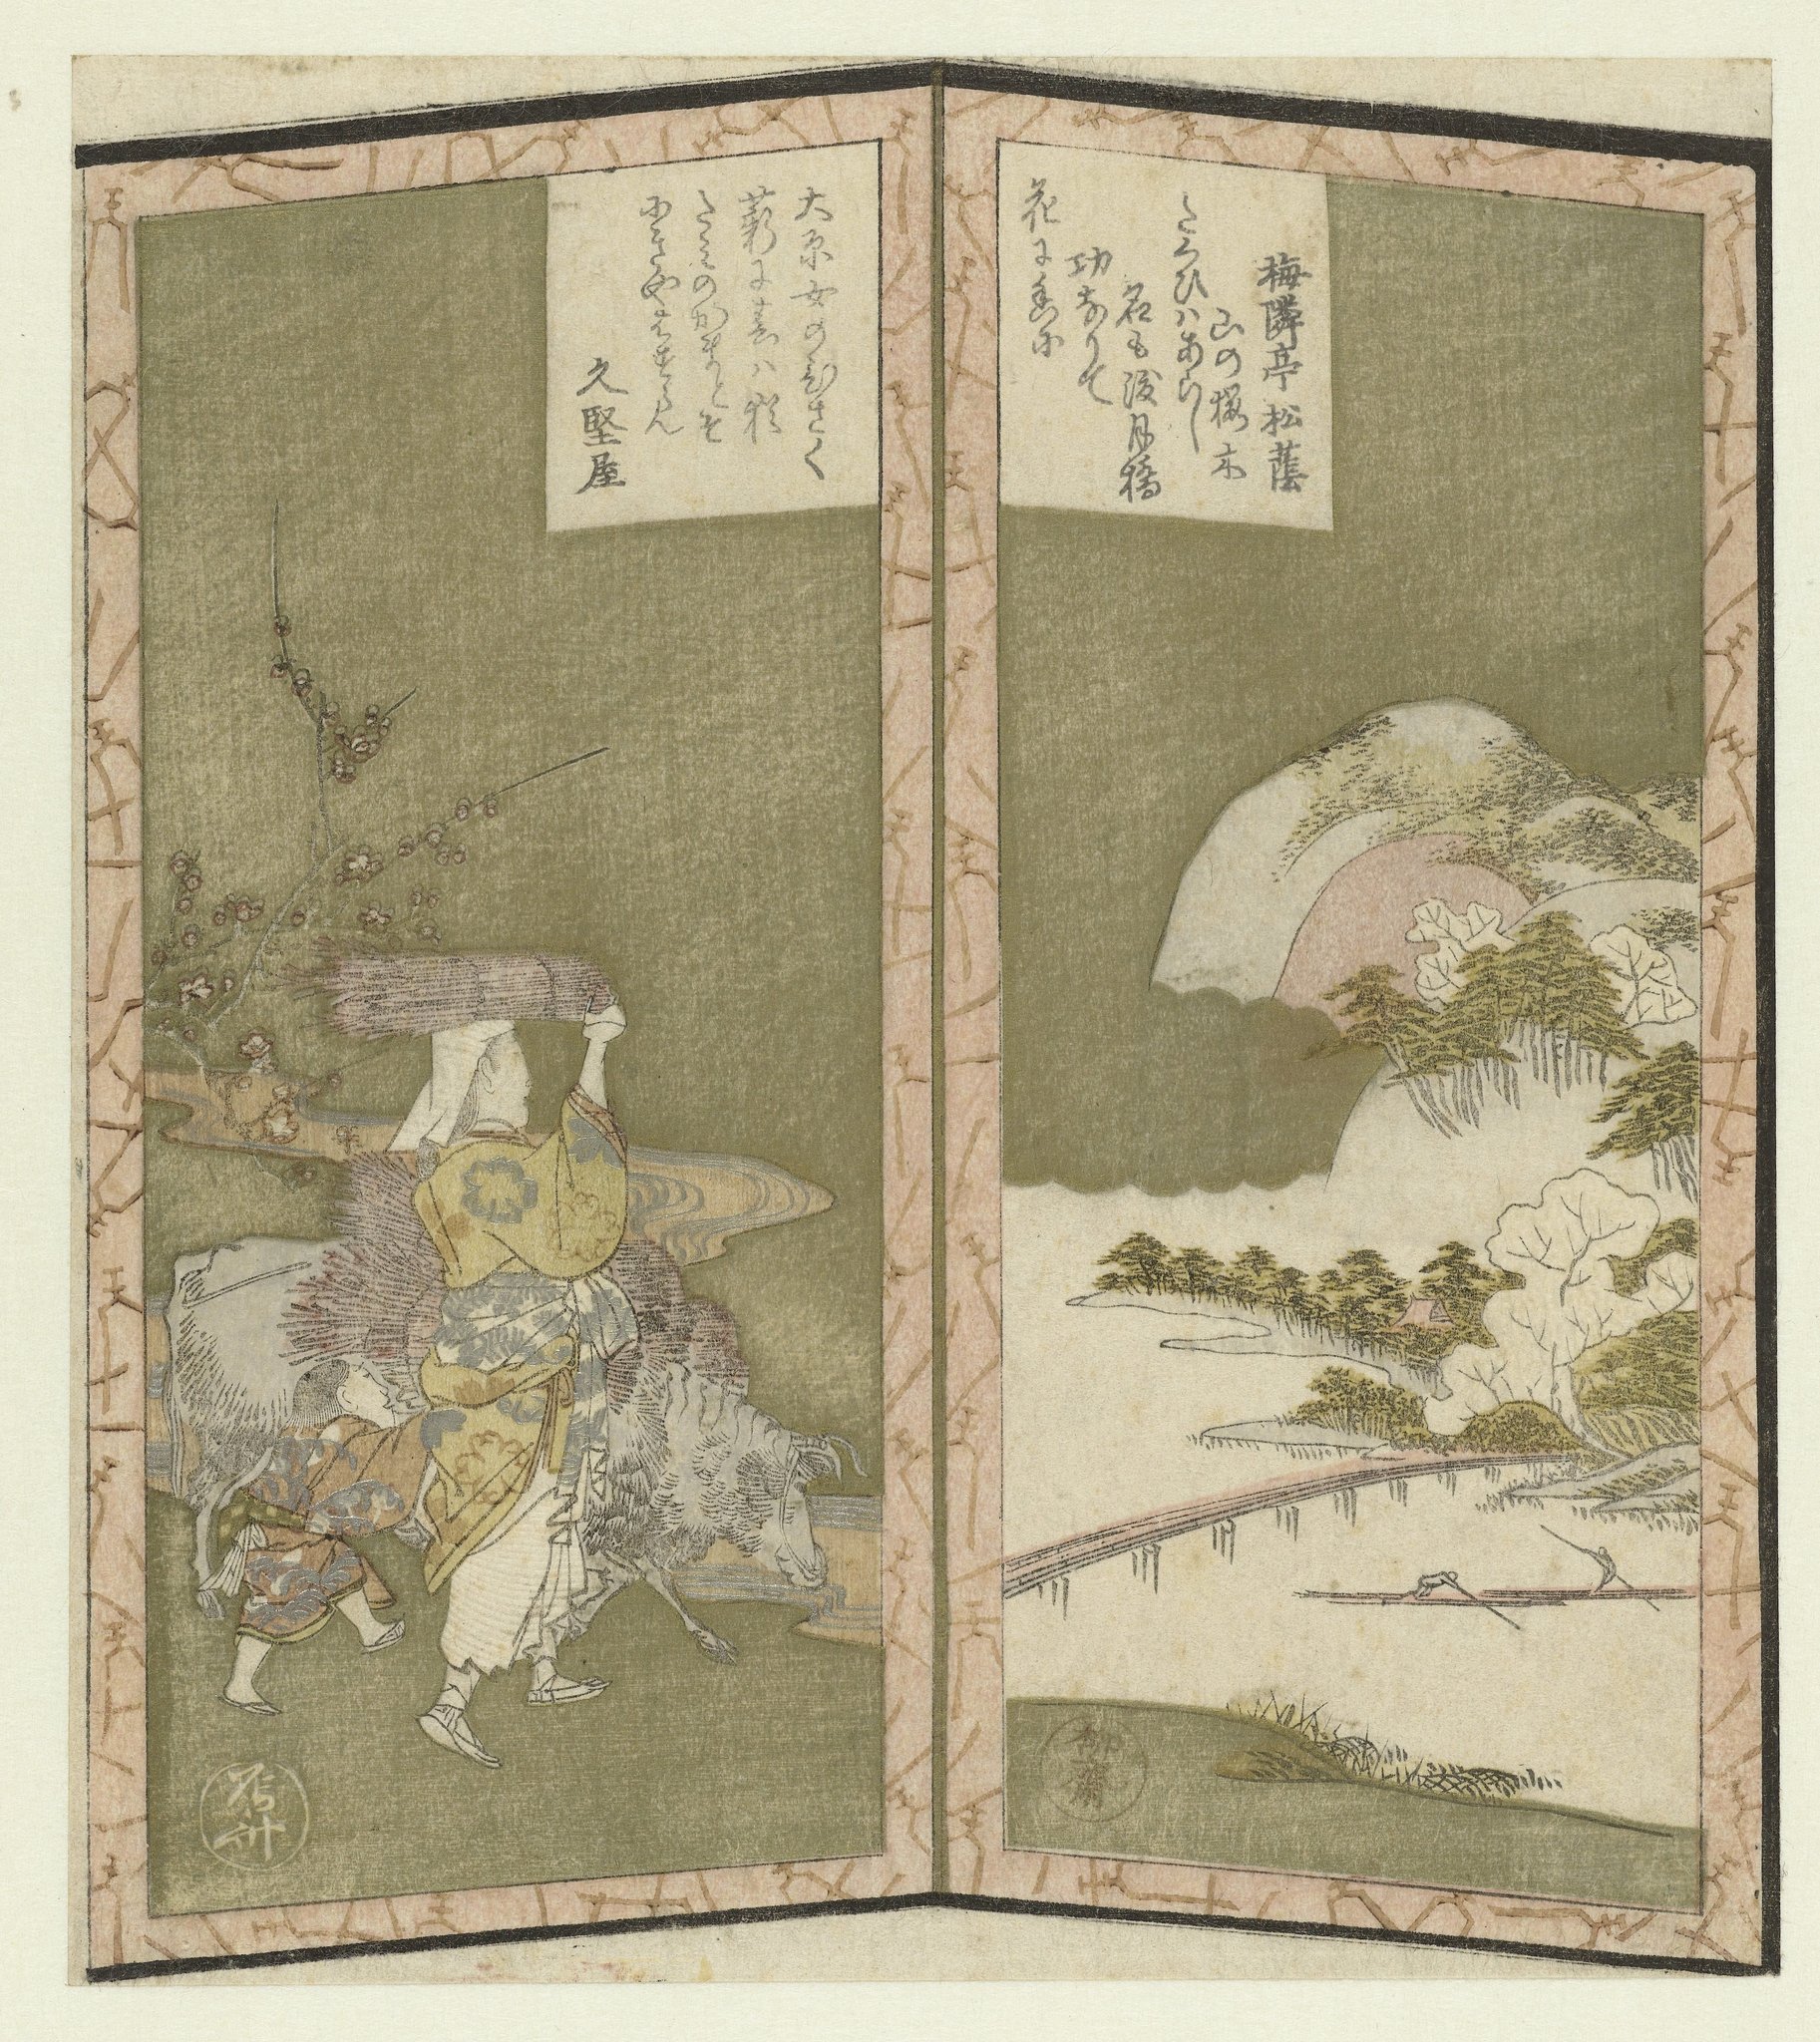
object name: surimono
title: Landscape and Ôharame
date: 1825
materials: paper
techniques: blind stamped, woodcut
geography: japan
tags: screen, folding screen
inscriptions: collector's mark, passe-partout, bottom left, printed: JABdH with a rooster., collector's mark, verso, stamped: Lugt 2228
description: Een surimono is een luxe uitgevoerde prent waarop beeld met één of meerdere gedichten gecombineerd is. Bij het drukken van een surimono werd vaak gebruik gemaakt van dikker papier, blinddruk en metaal pigmenten, zoals koper- en zilverpoeder. De prenten werden vaak in opdracht van dichters gemaakt en als exclusief geschenk aan vrienden en relaties gegeven.